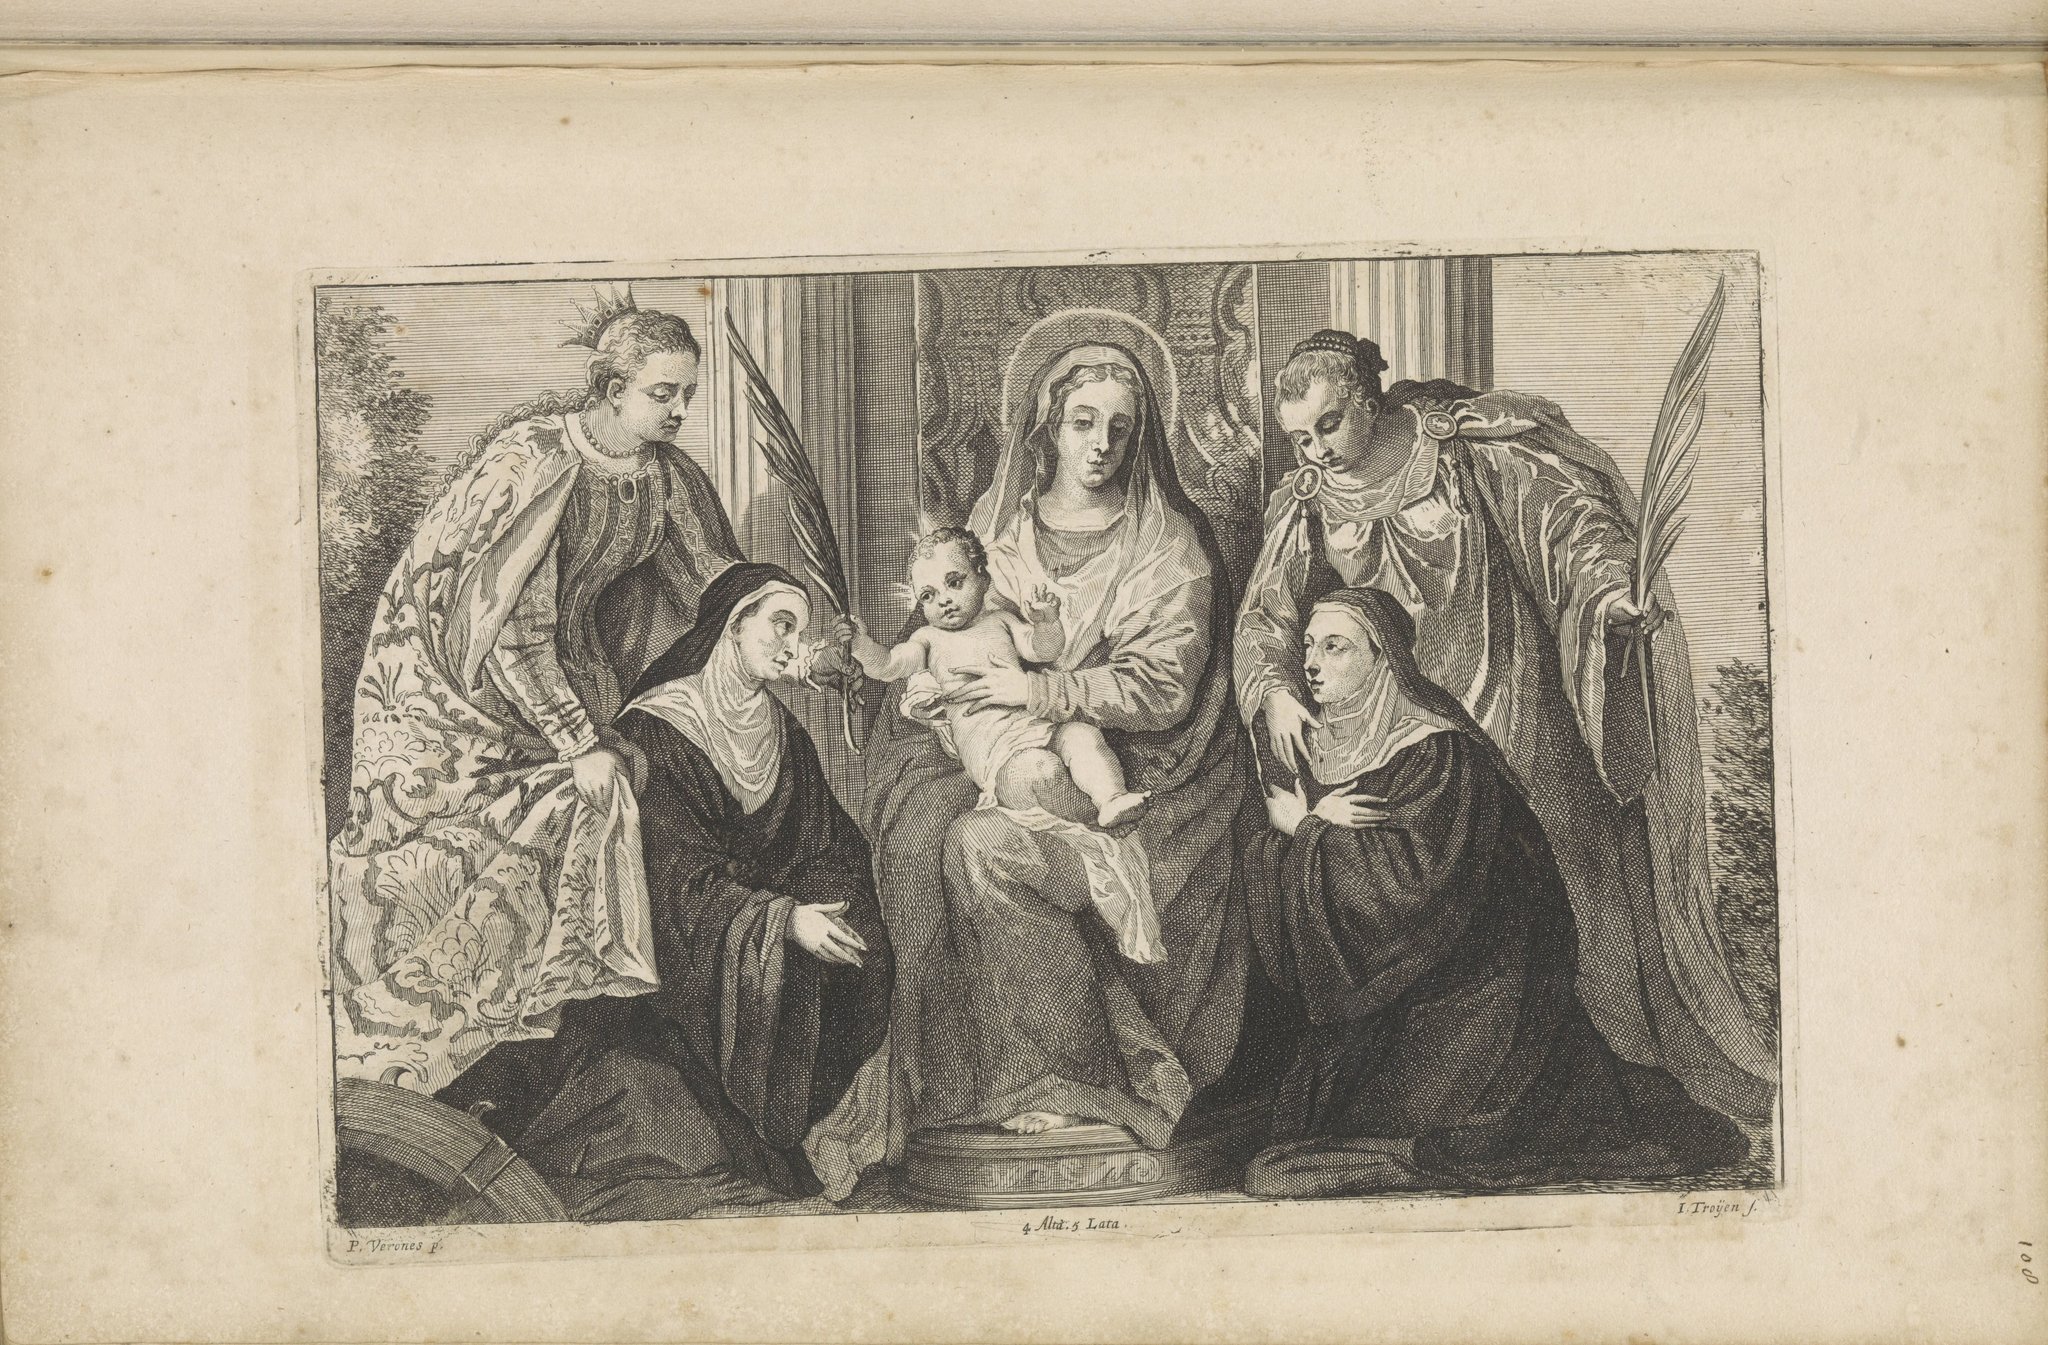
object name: album leaf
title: Maria met het Christuskind, de H. Lucia, de H. Catharina van Alexandrië en twee stichters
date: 1660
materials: paper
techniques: etching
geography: brussels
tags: the virgin martyr lucy (lucia) of syracuse; possible attributes: dagger or sword (in neck), eyes, flames at feet, lamp, ox (+ donor(s), supplicant(s), whether or not with patron saint(s)), the virgin martyr catherine of alexandria; possible attributes: book, crown, emperor maxentius, palm-branch, ring, sword, wheel (+ donor(s), supplicant(s), whether or not with patron saint(s)), mary sitting or enthroned, the christ-child in front of her, sitting in her lap (or in front of her bosom)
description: De prent is vervaardigd naar het schilderij van Veronese dat zich in de collectie van het Kunsthistorisches Museum te Wenen bevindt (inventarisnummer GG_50). David Teniers heeft waarschijnlijk van alle schilderijen uit de collectie van Leopold Willem van Oostenrijk een olieverfstudie op doek of paneel vervaardigd (zgn. pasticcio), die als voorbeeld voor de prentmakers diende. Het is niet altijd duidelijk of de pasticci door hem zijn gemaakt of door zijn atelier. Niet alle pasticci zijn overgeleverd.